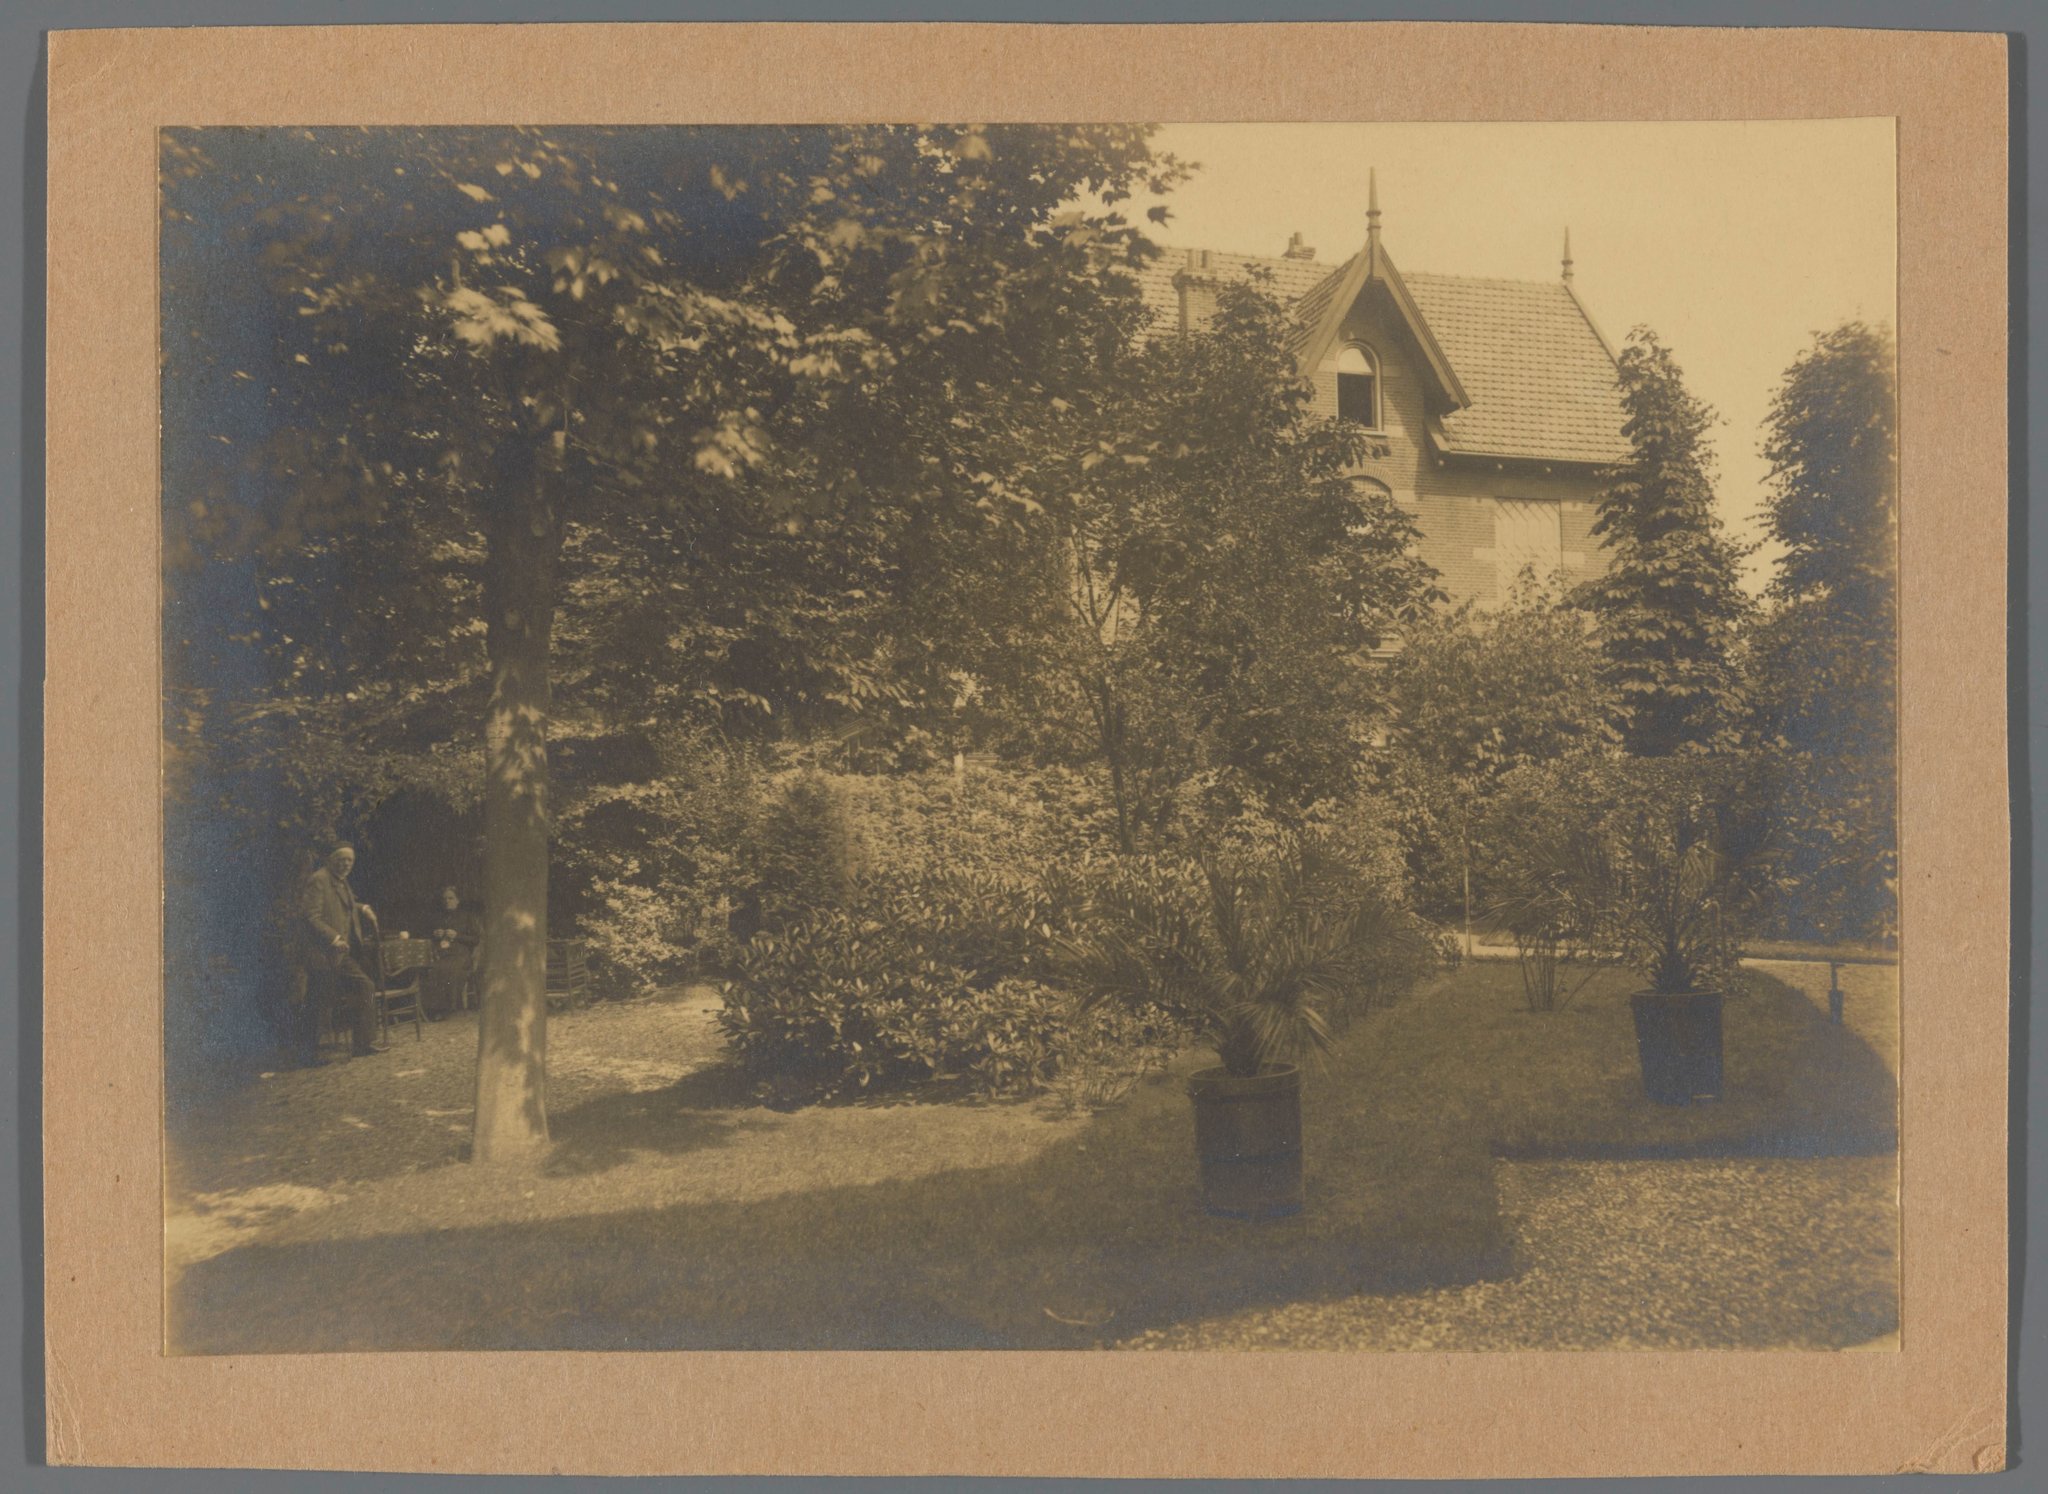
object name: photograph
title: Gezicht op een tuin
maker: cornelia hendrika jonker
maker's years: 1874-1924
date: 1915-1940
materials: cardboard, photographic support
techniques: gelatin silver print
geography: bussum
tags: garden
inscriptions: annotation: ‘Tuin buurman/ Bussum’